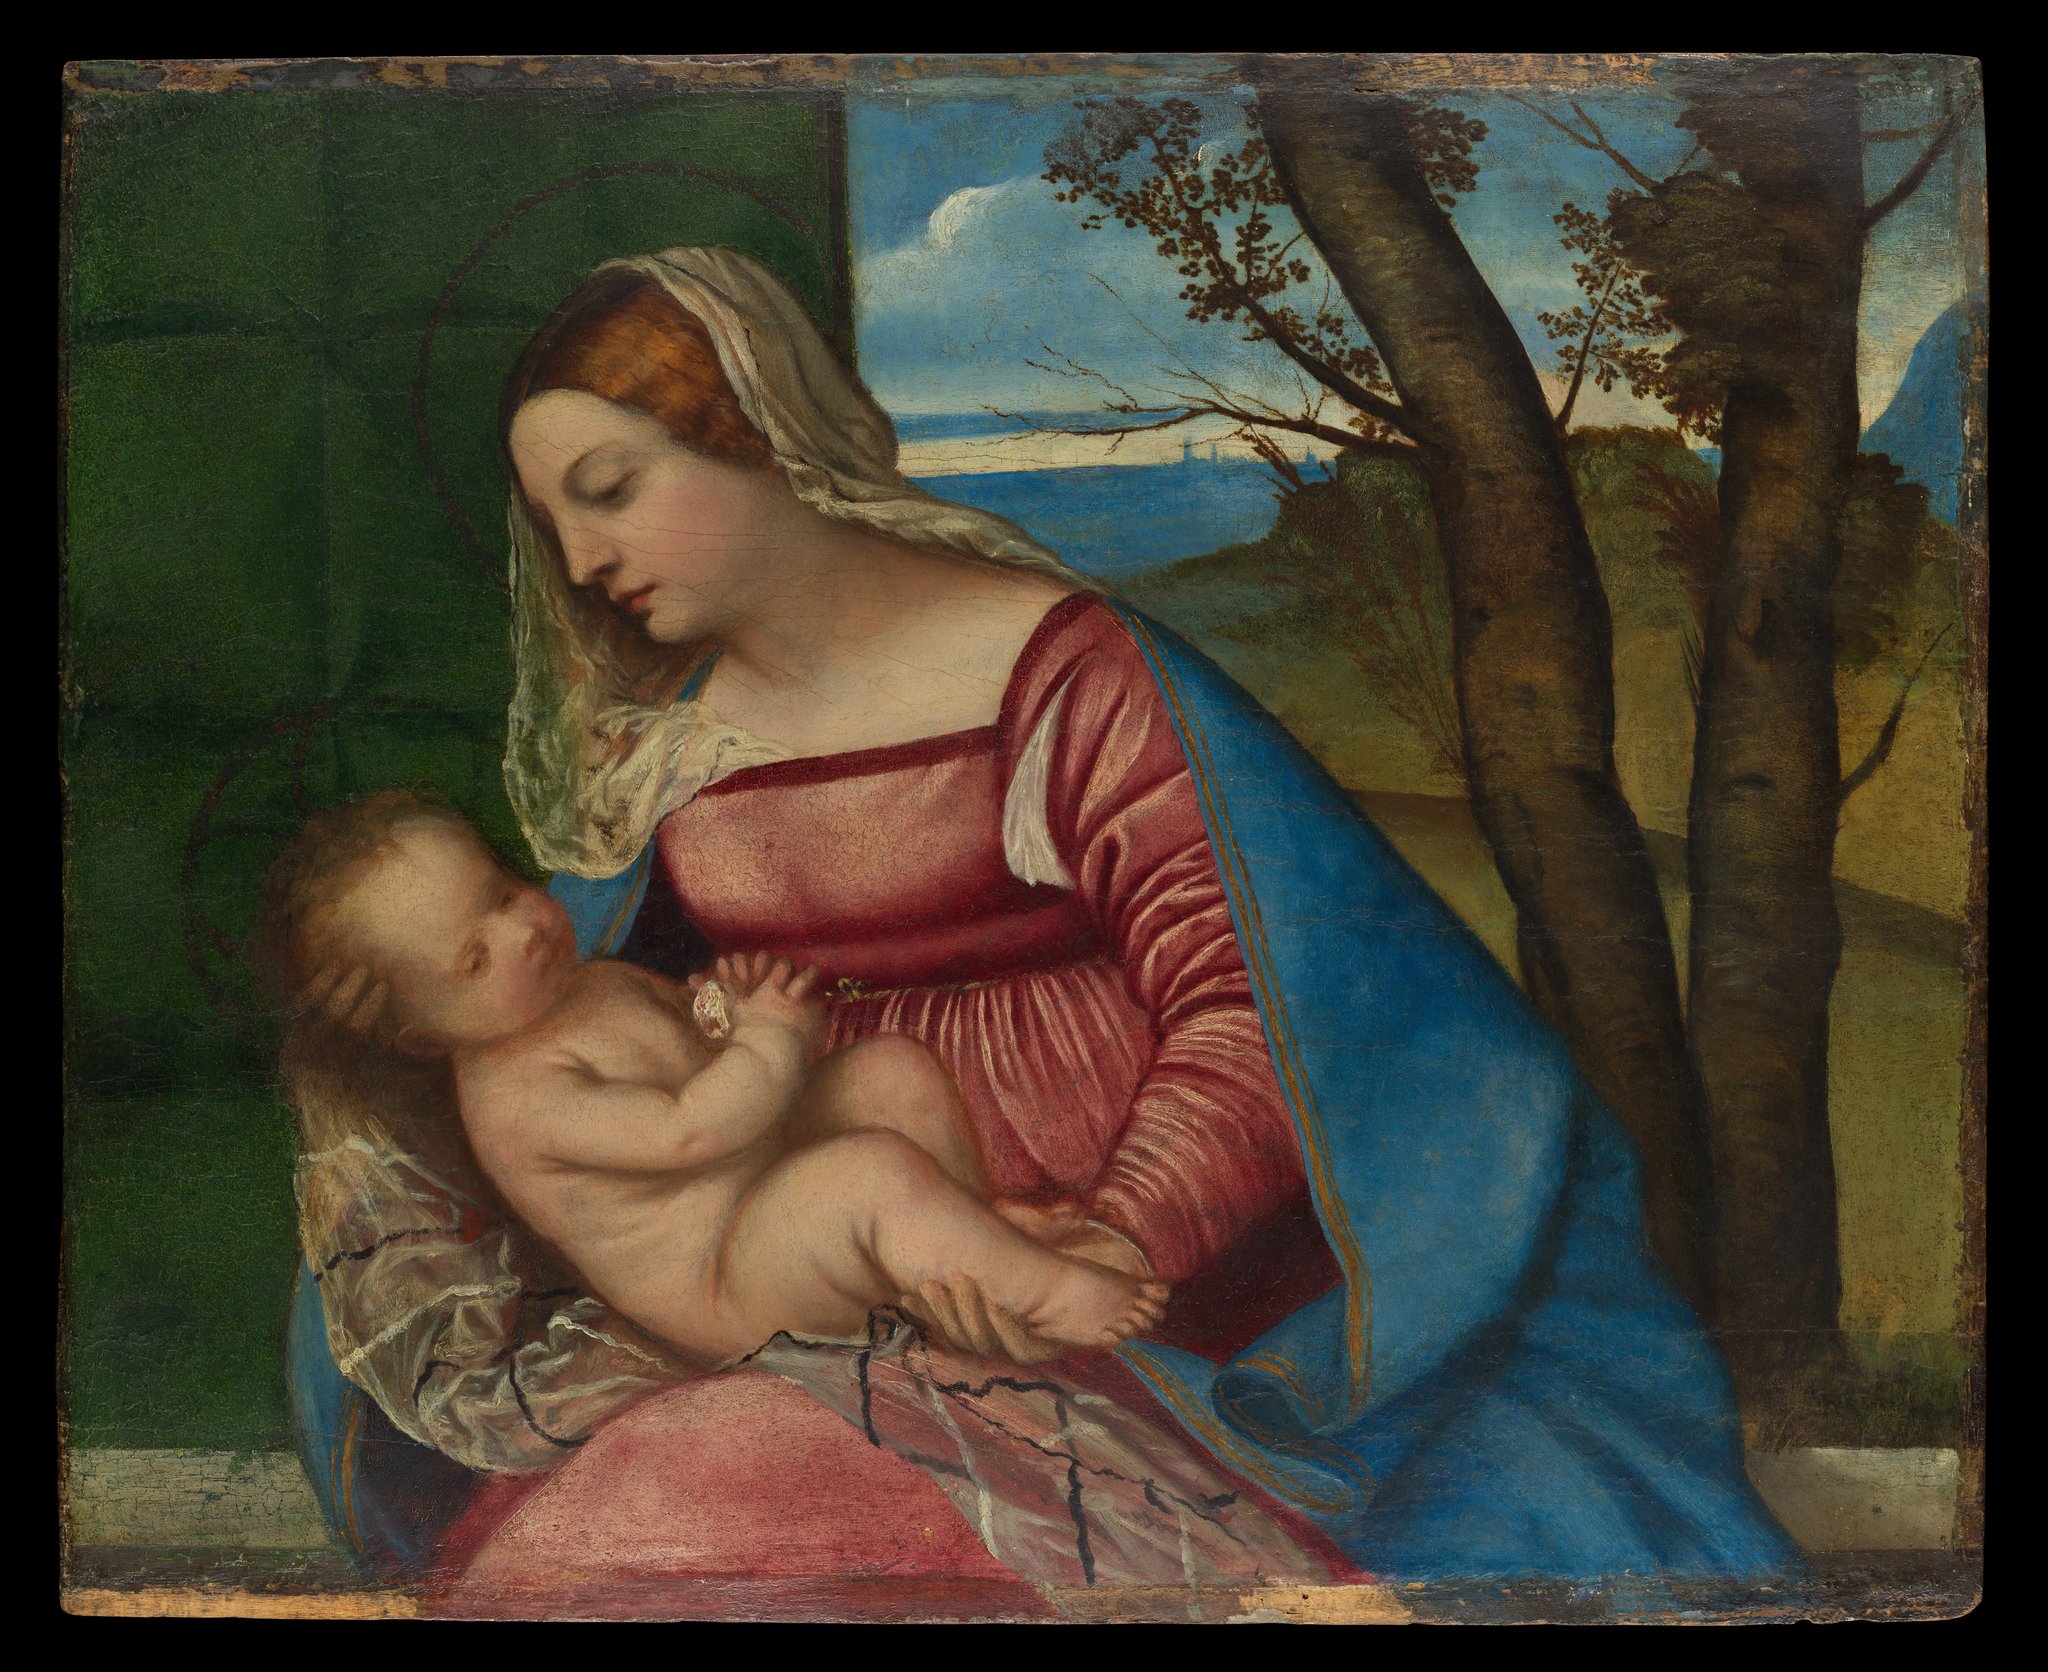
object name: painting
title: Madonna and Child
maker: titian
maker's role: artist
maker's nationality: italian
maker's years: 1485-1576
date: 1508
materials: oil, wood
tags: madonna and child